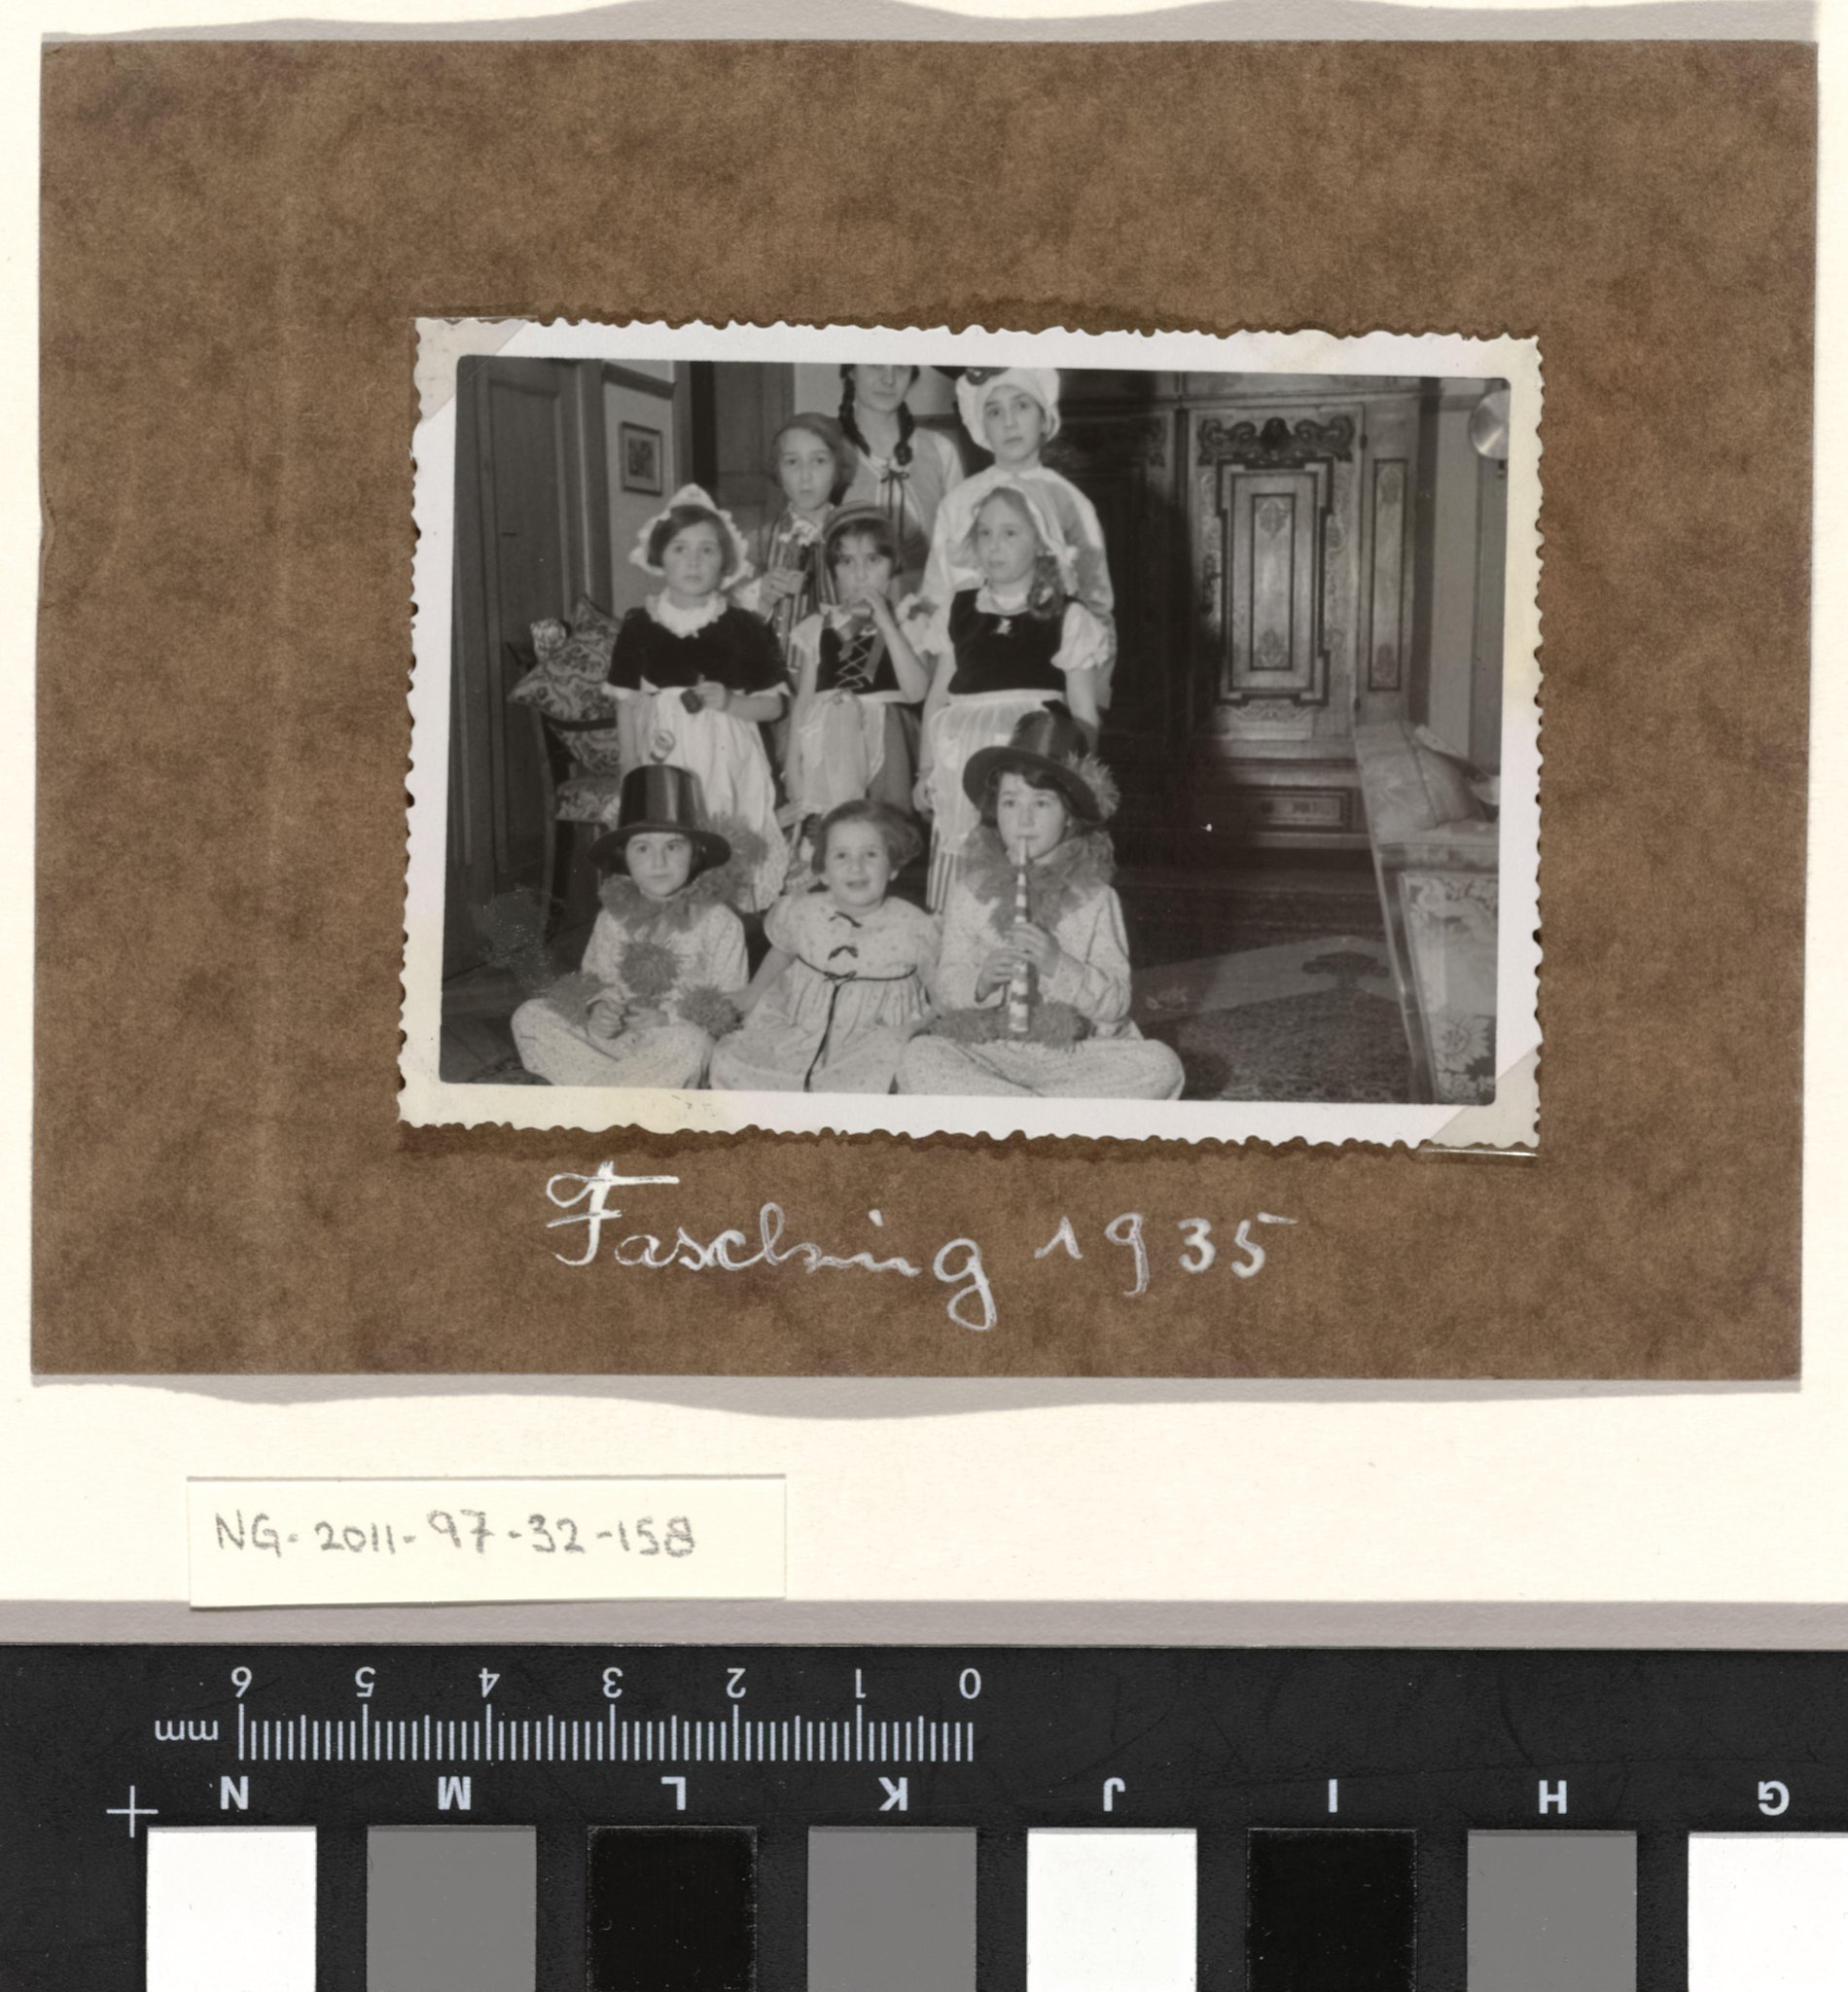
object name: photograph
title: Isabel Wachenheimer tijdens carnaval, in maart 1935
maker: Anonymous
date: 1902-1935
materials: photographic support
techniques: gelatin silver print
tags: leiden, isabel wachenheimer-elon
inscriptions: date: ‘Fasching 1935’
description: Isabel Wachenheimer (midden, foor) tijdens carnaval.